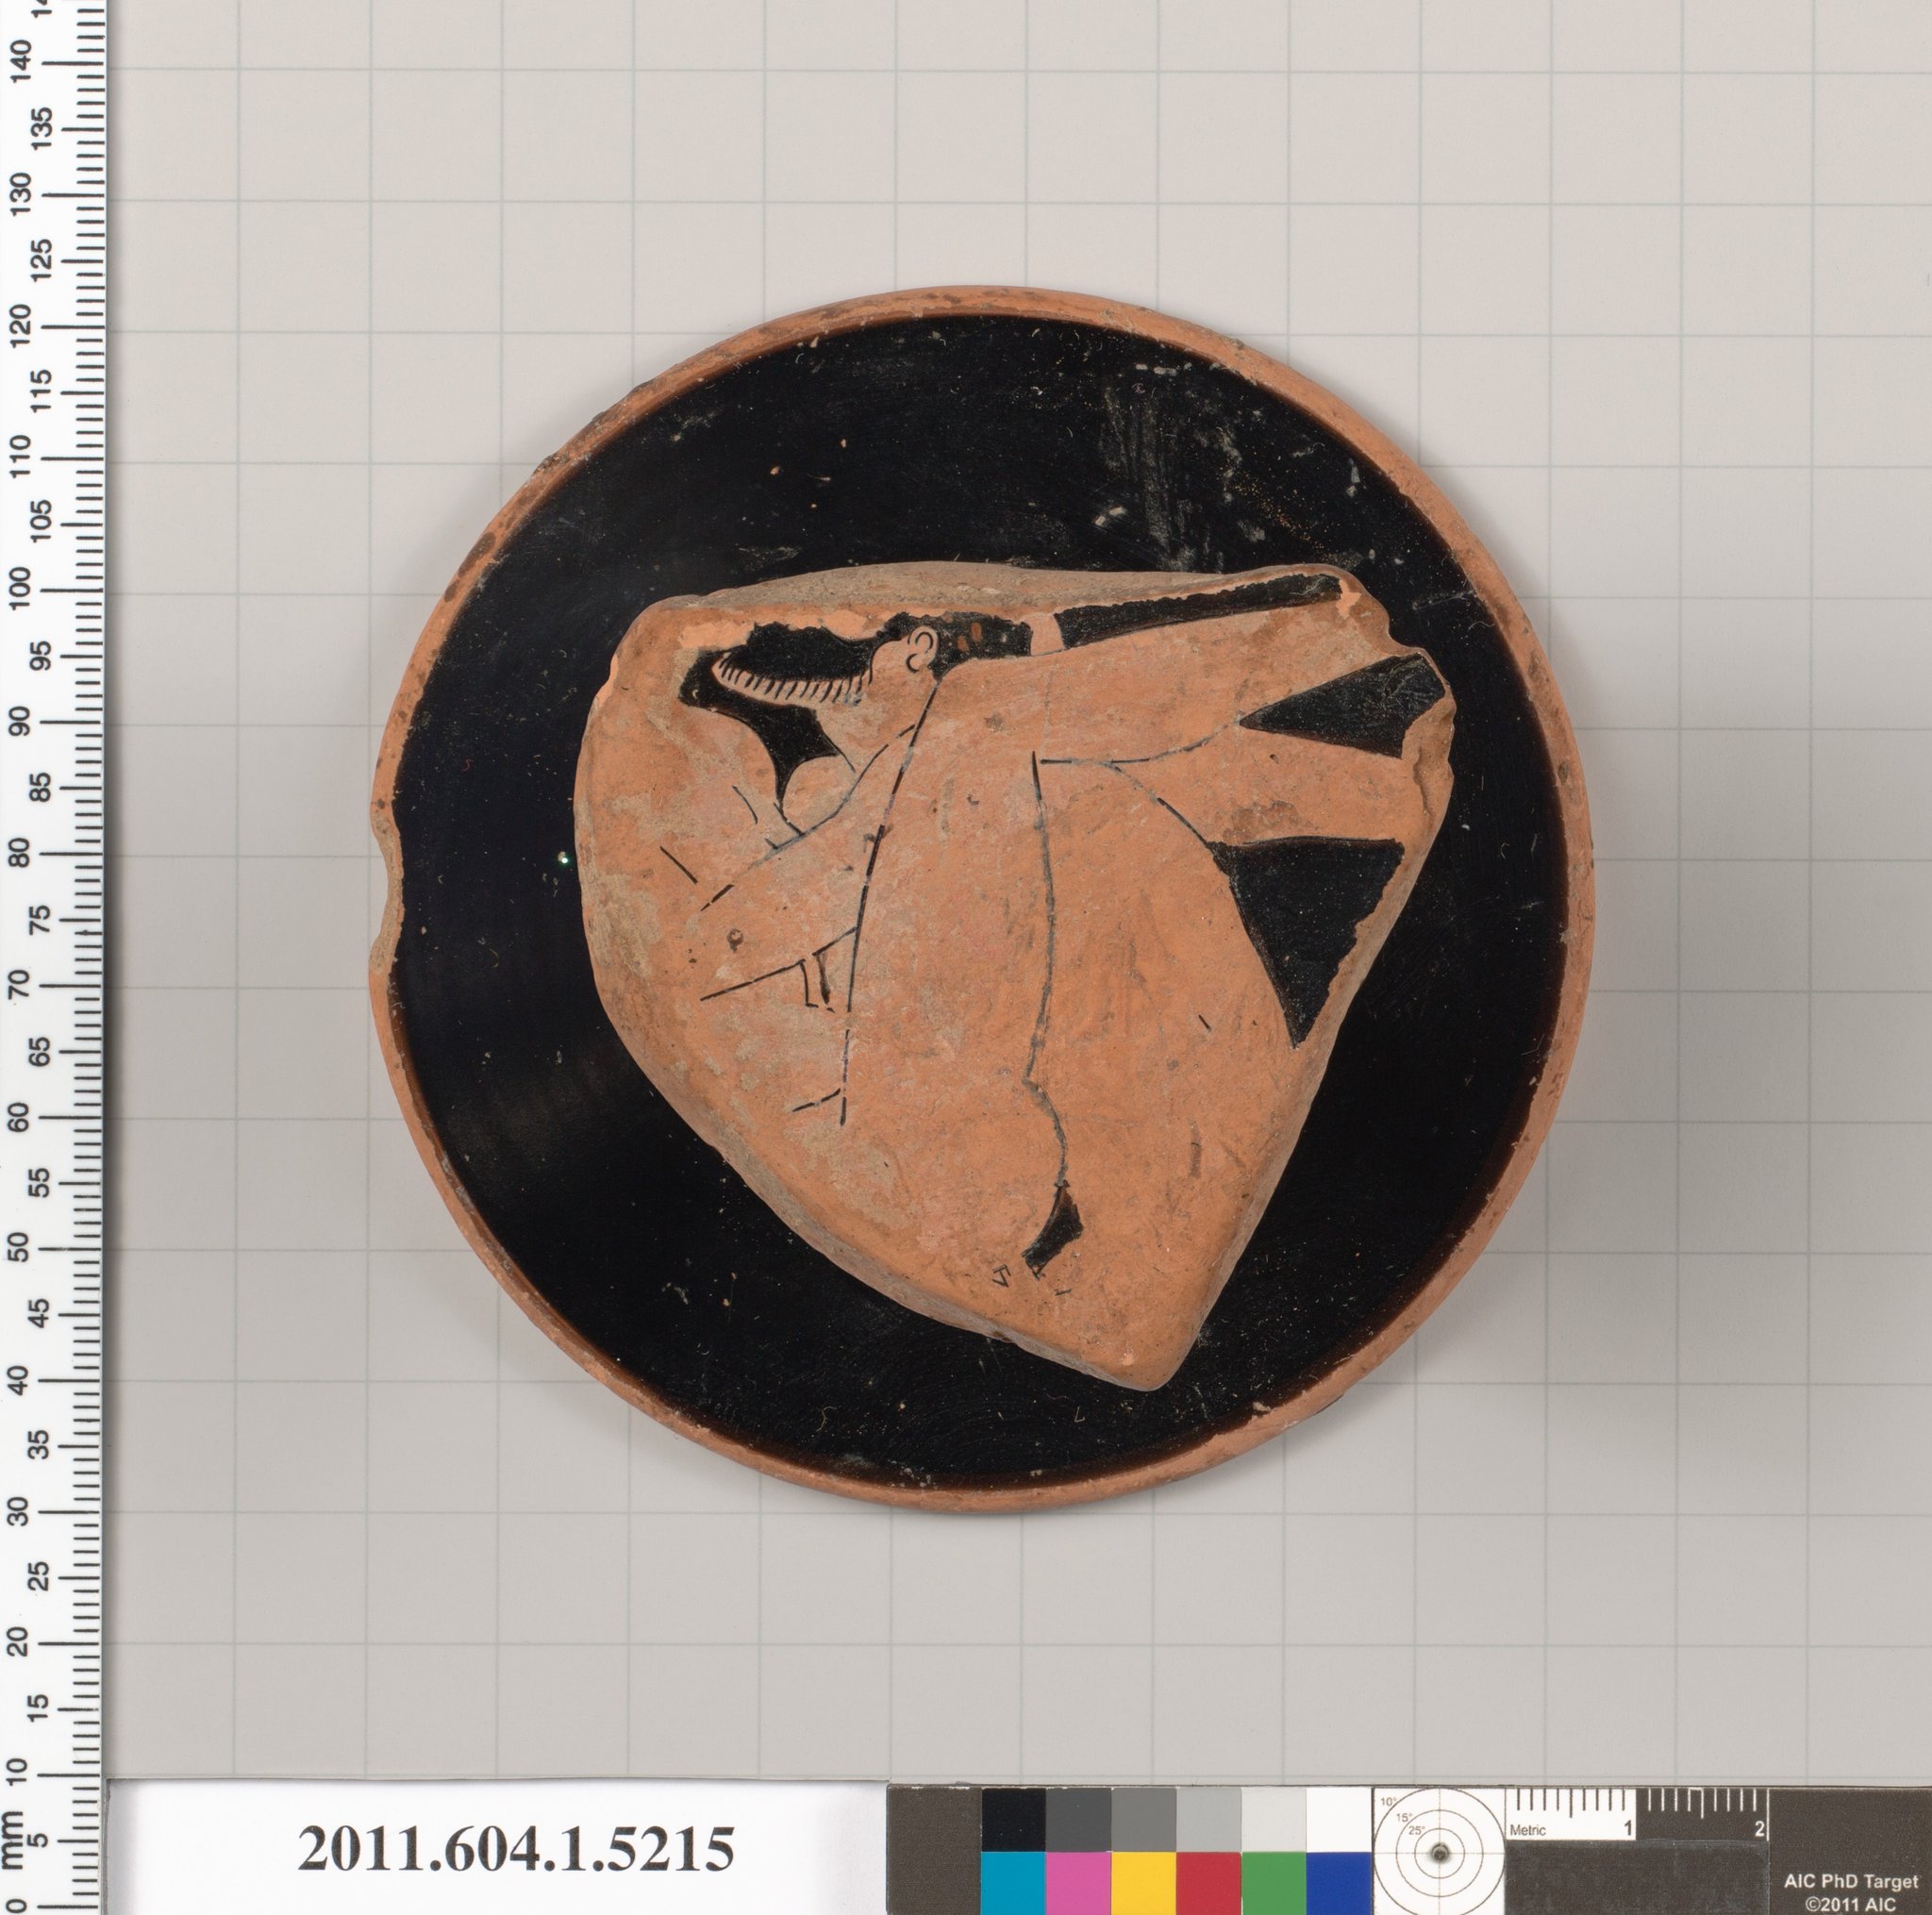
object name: kylix fragment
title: Terracotta fragment of a kylix (drinking cup)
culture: greek, attic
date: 500-480 BCE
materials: terracotta